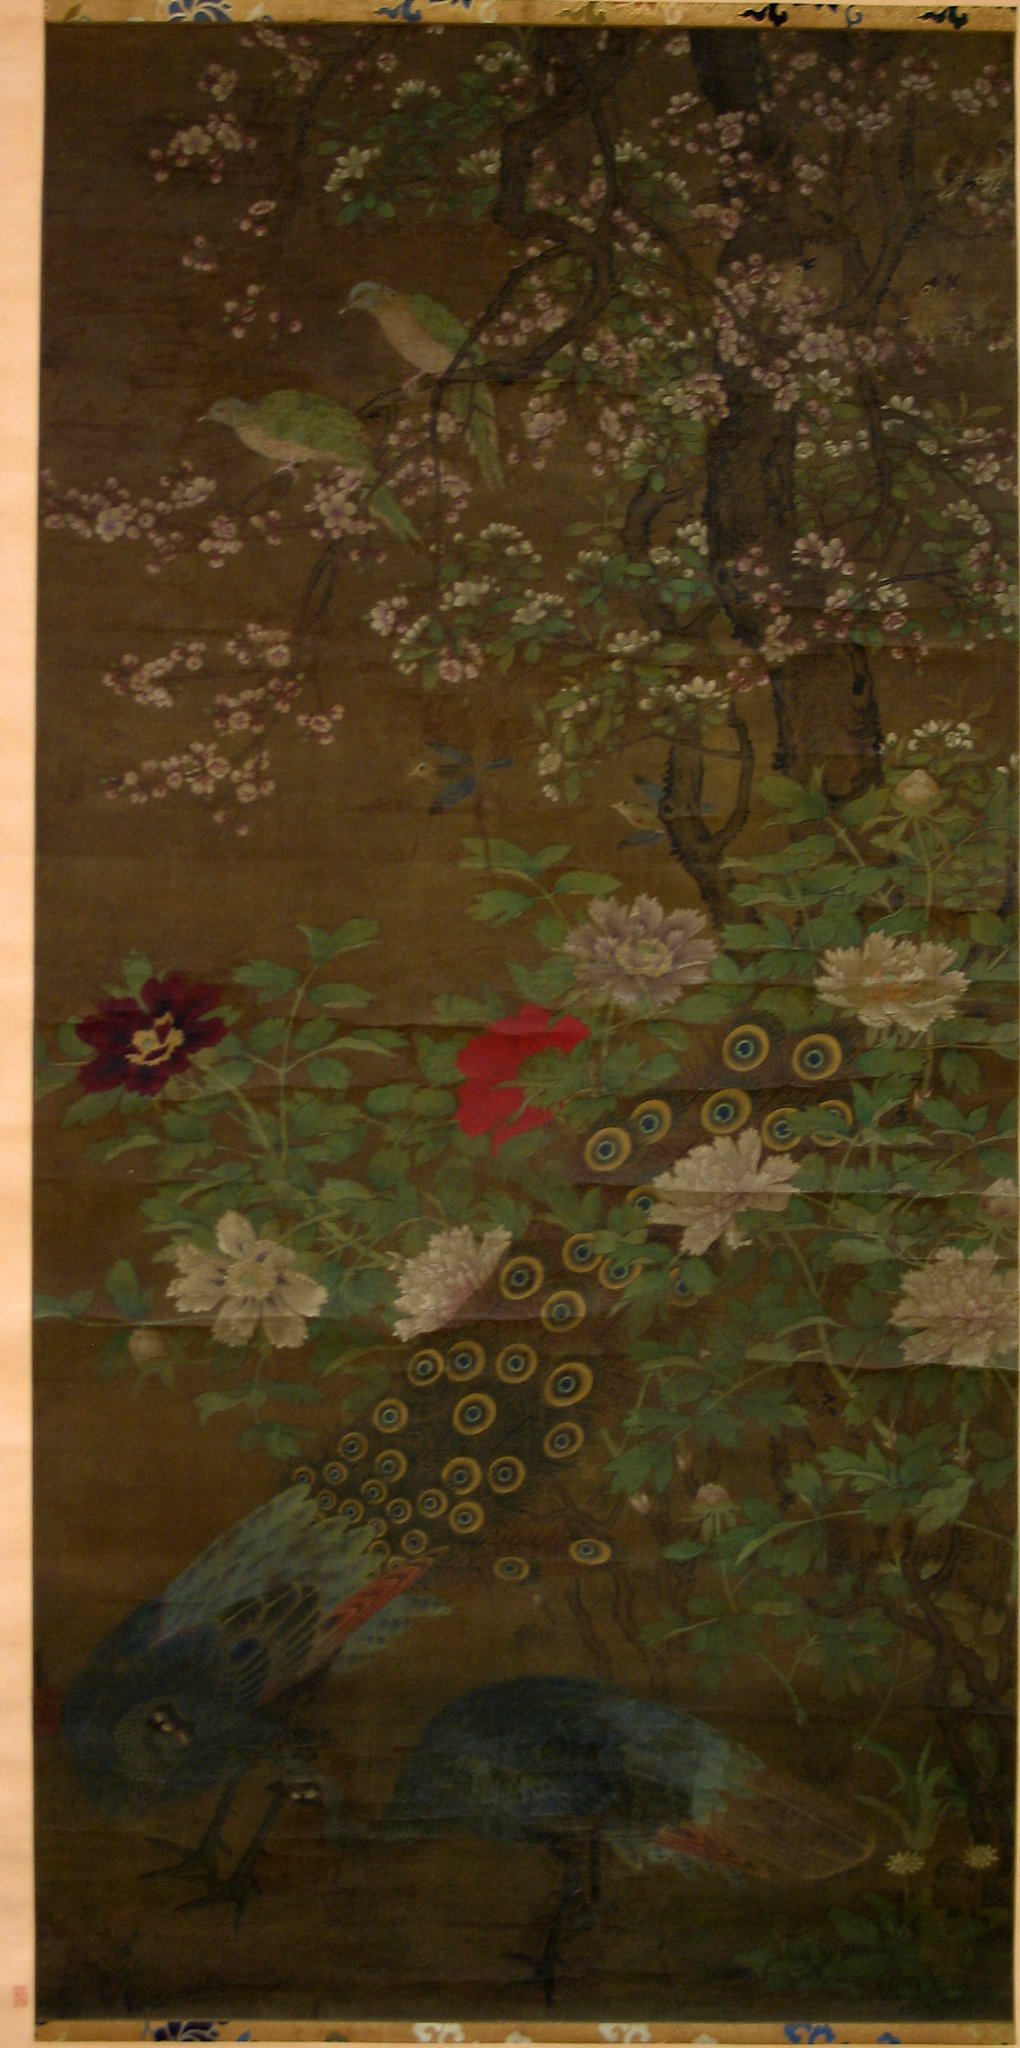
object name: hanging scroll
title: Birds and Flowers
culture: chinese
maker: unidentified artist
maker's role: artist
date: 1368-1911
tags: birds,peacocks,flowers